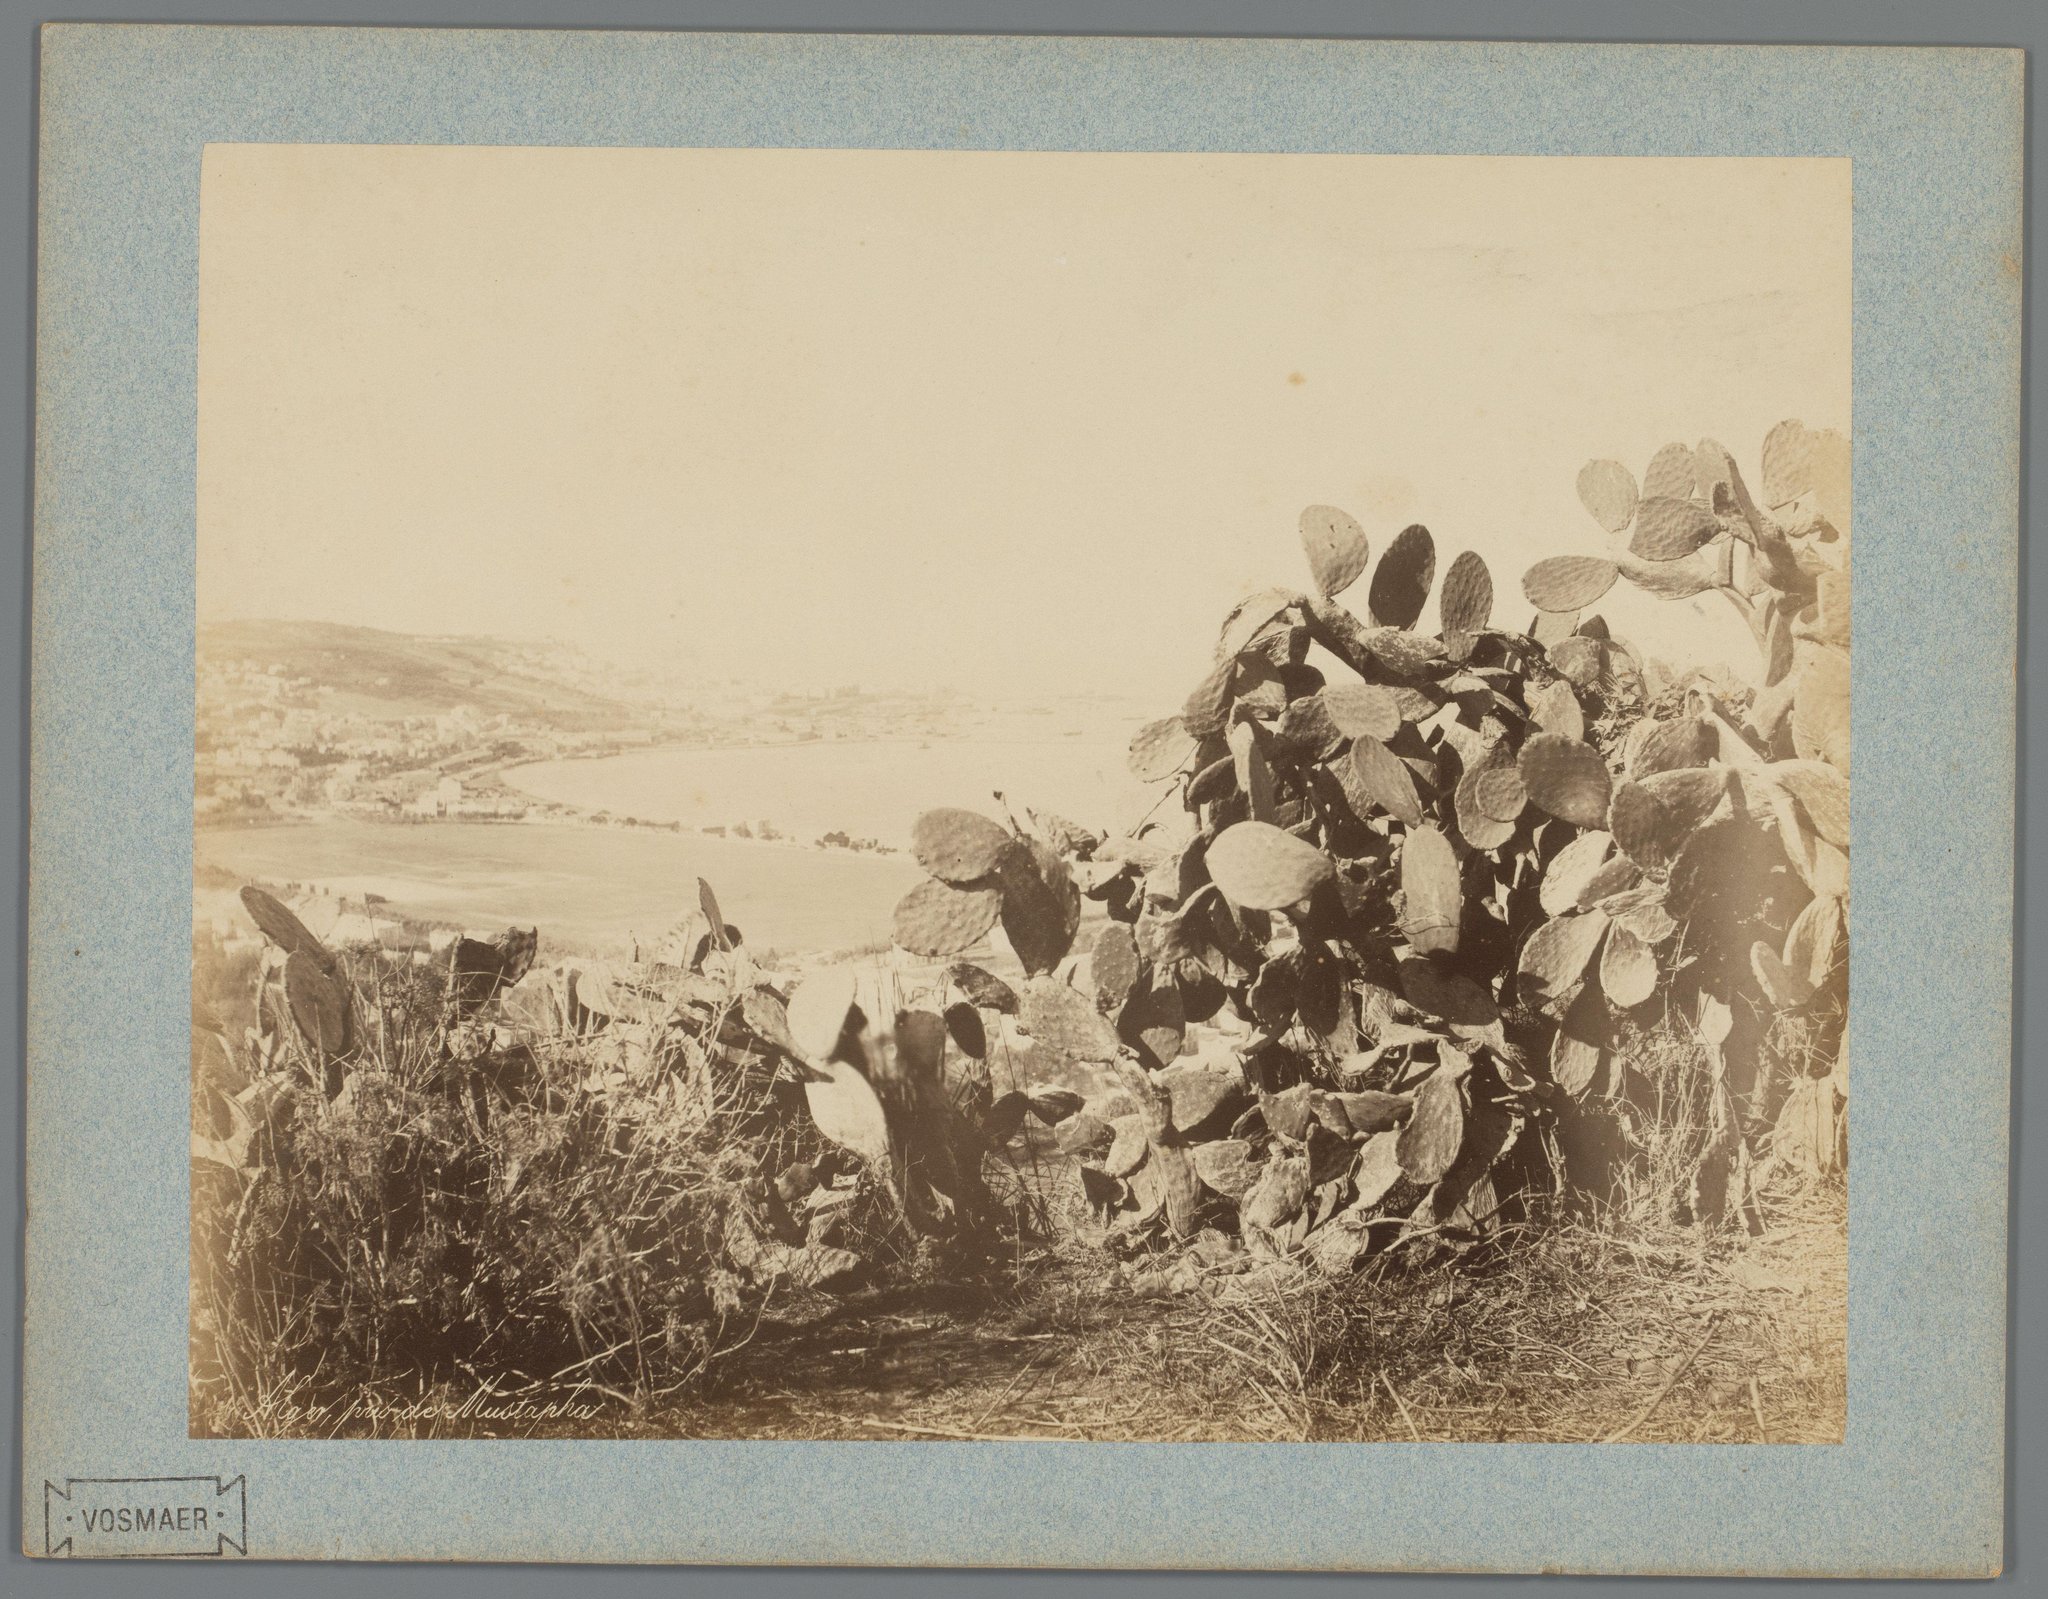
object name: photograph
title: Cactussen in Mustapha bij Algiers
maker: Anonymous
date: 1851-1900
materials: cardboard, paper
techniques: albumen print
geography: algiers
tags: plants and herbs: cactus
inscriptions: collector's mark: ‘VOSMAER’